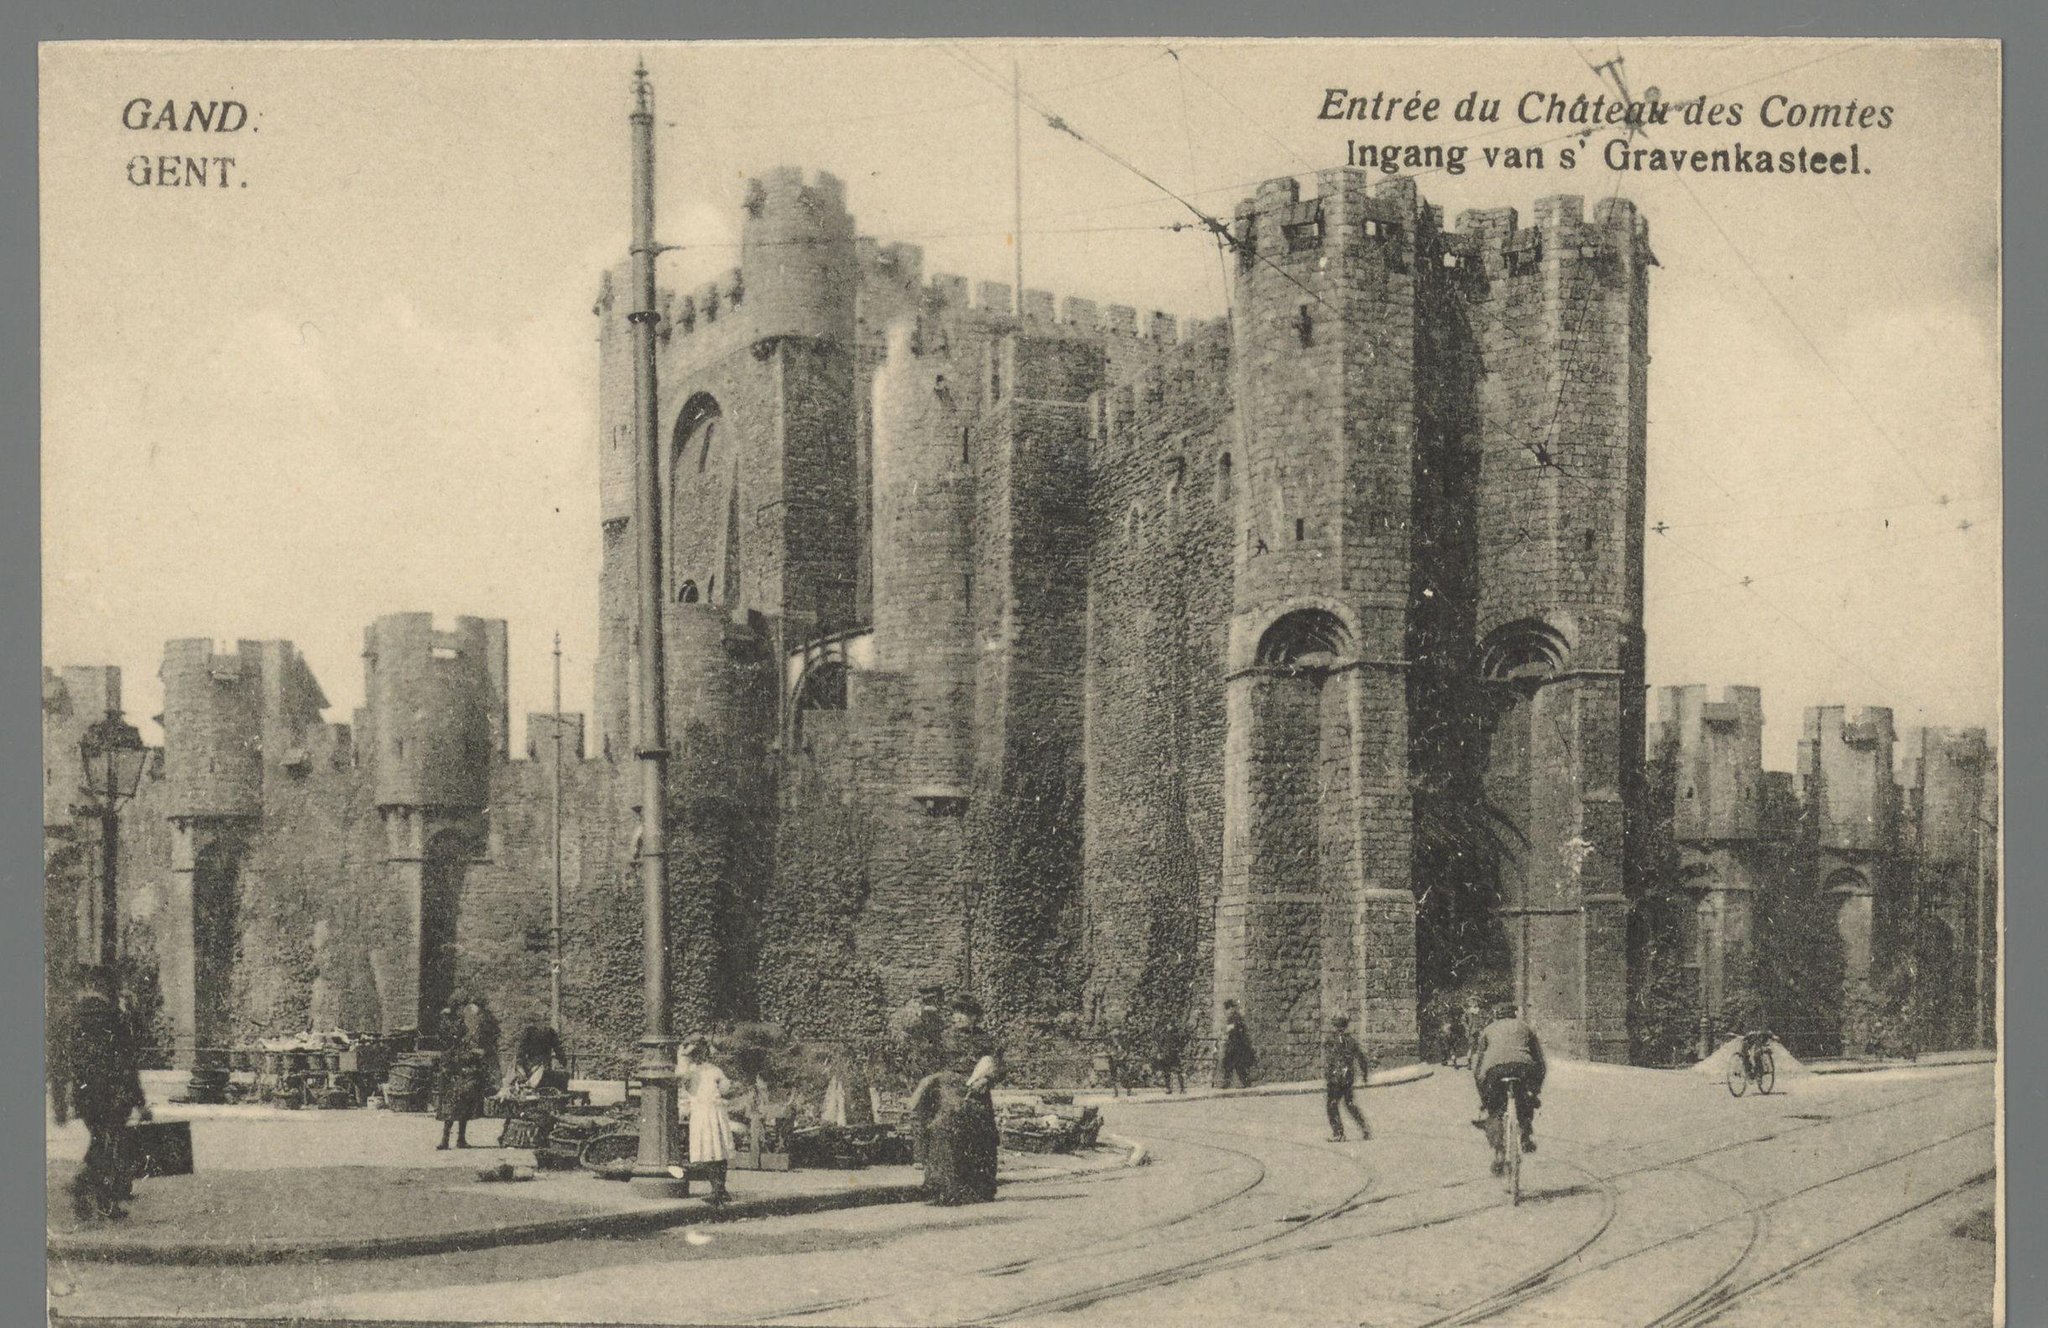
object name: ansichtkaart, prentbriefkaart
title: Gand. Entrée du Château des Comtes / Gent. Ingang van 's Gravenkasteel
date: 1906-1930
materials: cardboard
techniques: photograph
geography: ghent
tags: castle, city-view, and landscape with man-made constructions (+ city(-scape) with figures, staffage)